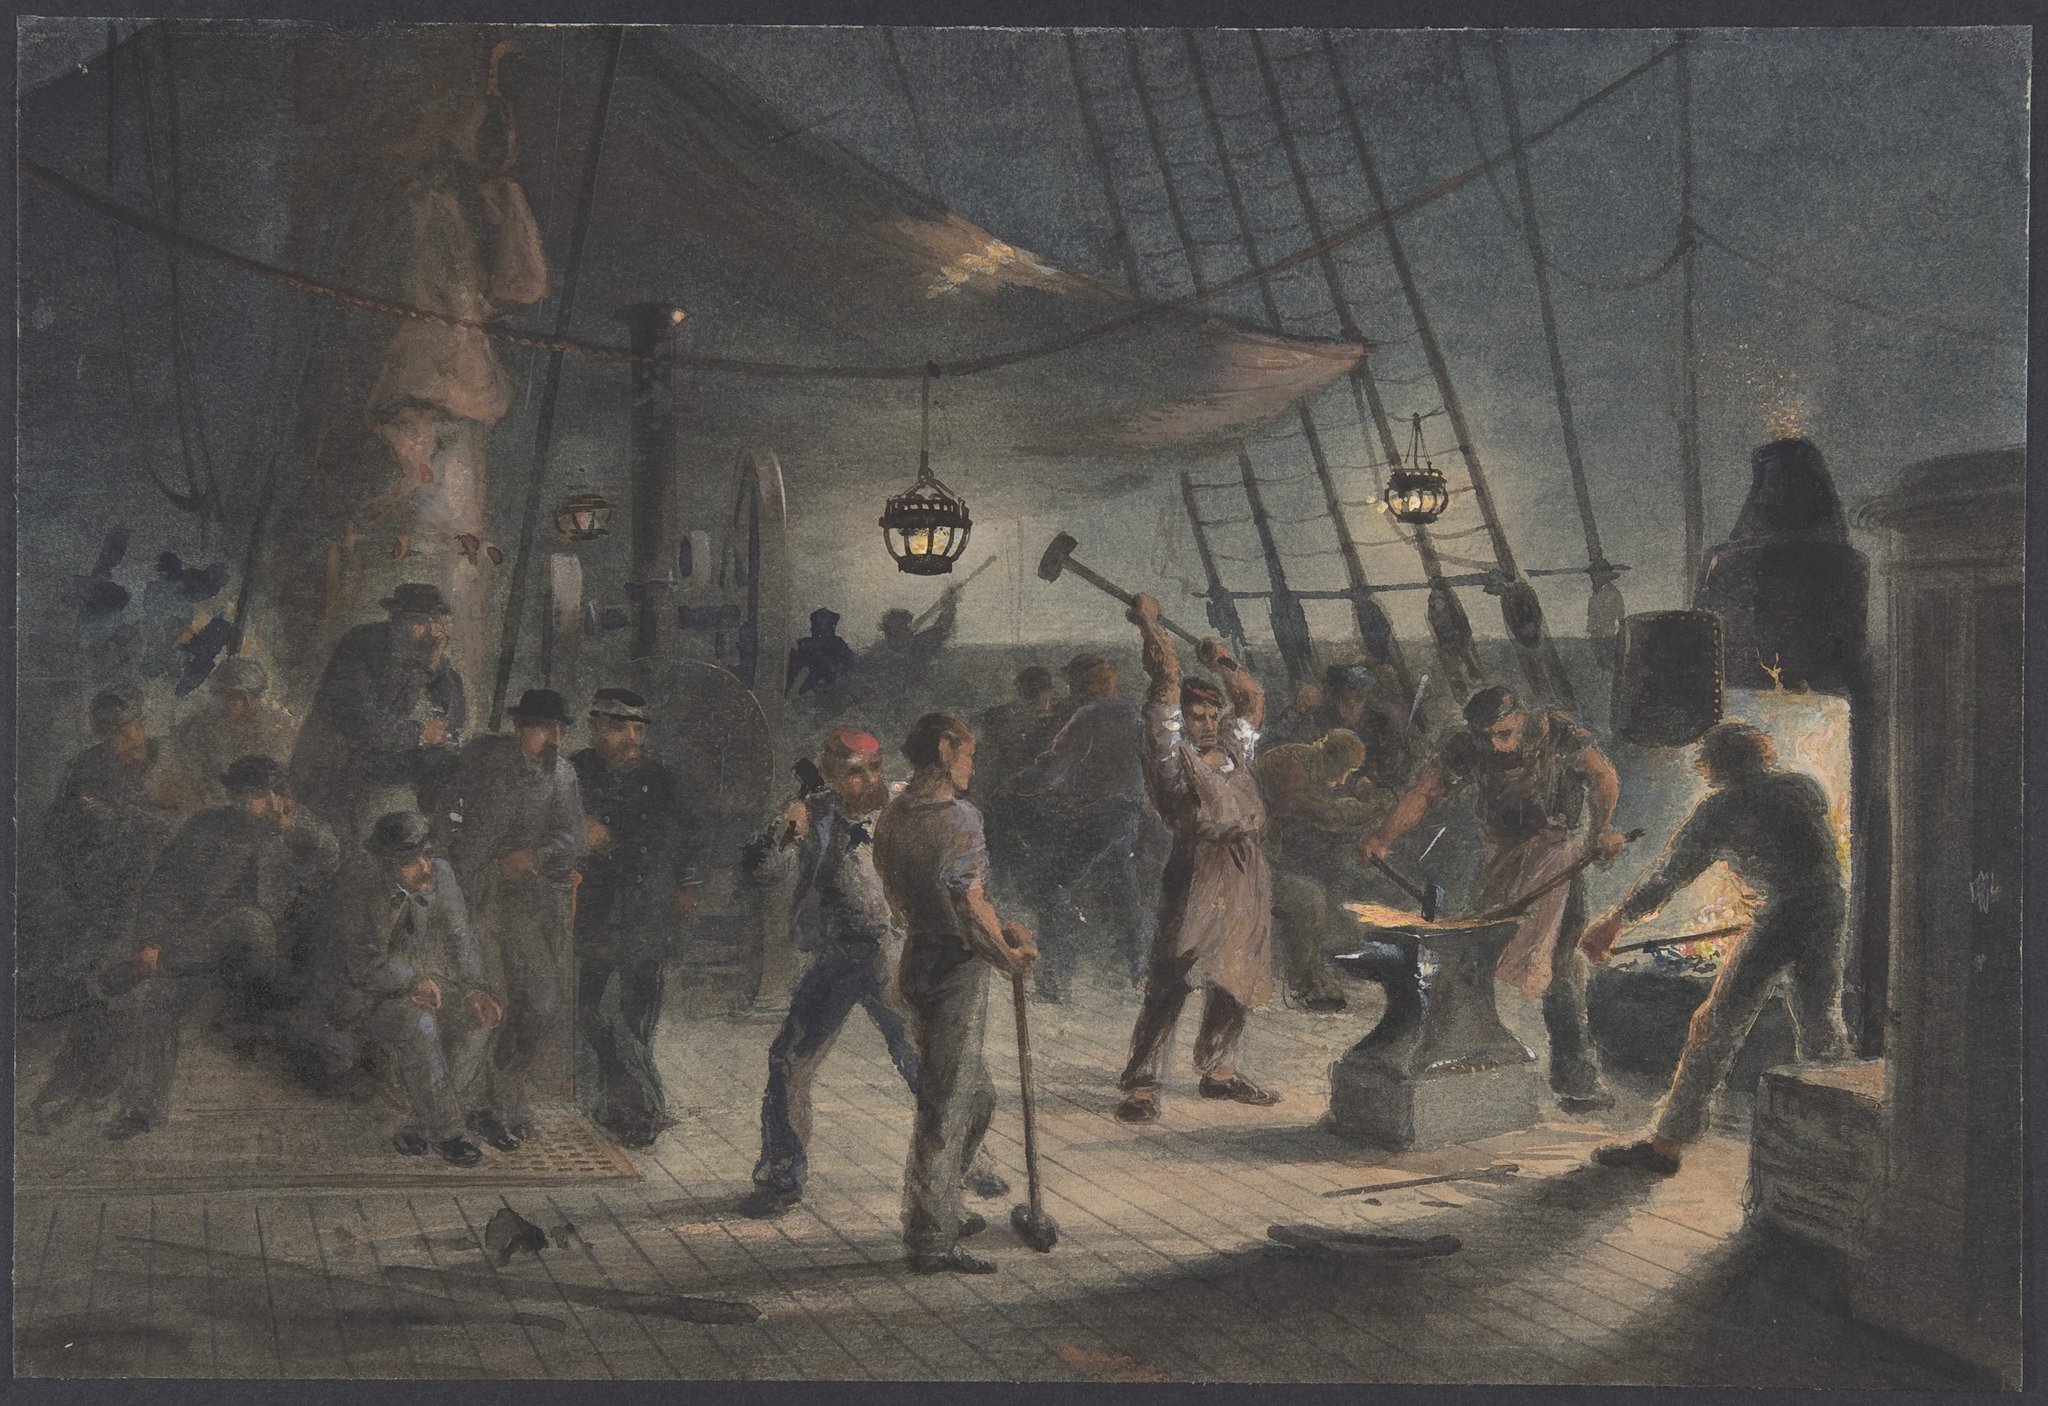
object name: drawing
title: The Forge on Deck, Night of August 9th: Preparing the Iron Plating for Capstan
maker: robert charles dudley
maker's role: artist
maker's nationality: british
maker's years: 1826-1909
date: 1865-1866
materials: gouache, graphite, watercolor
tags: men,working,industry,ships,hammers,transatlantic cable